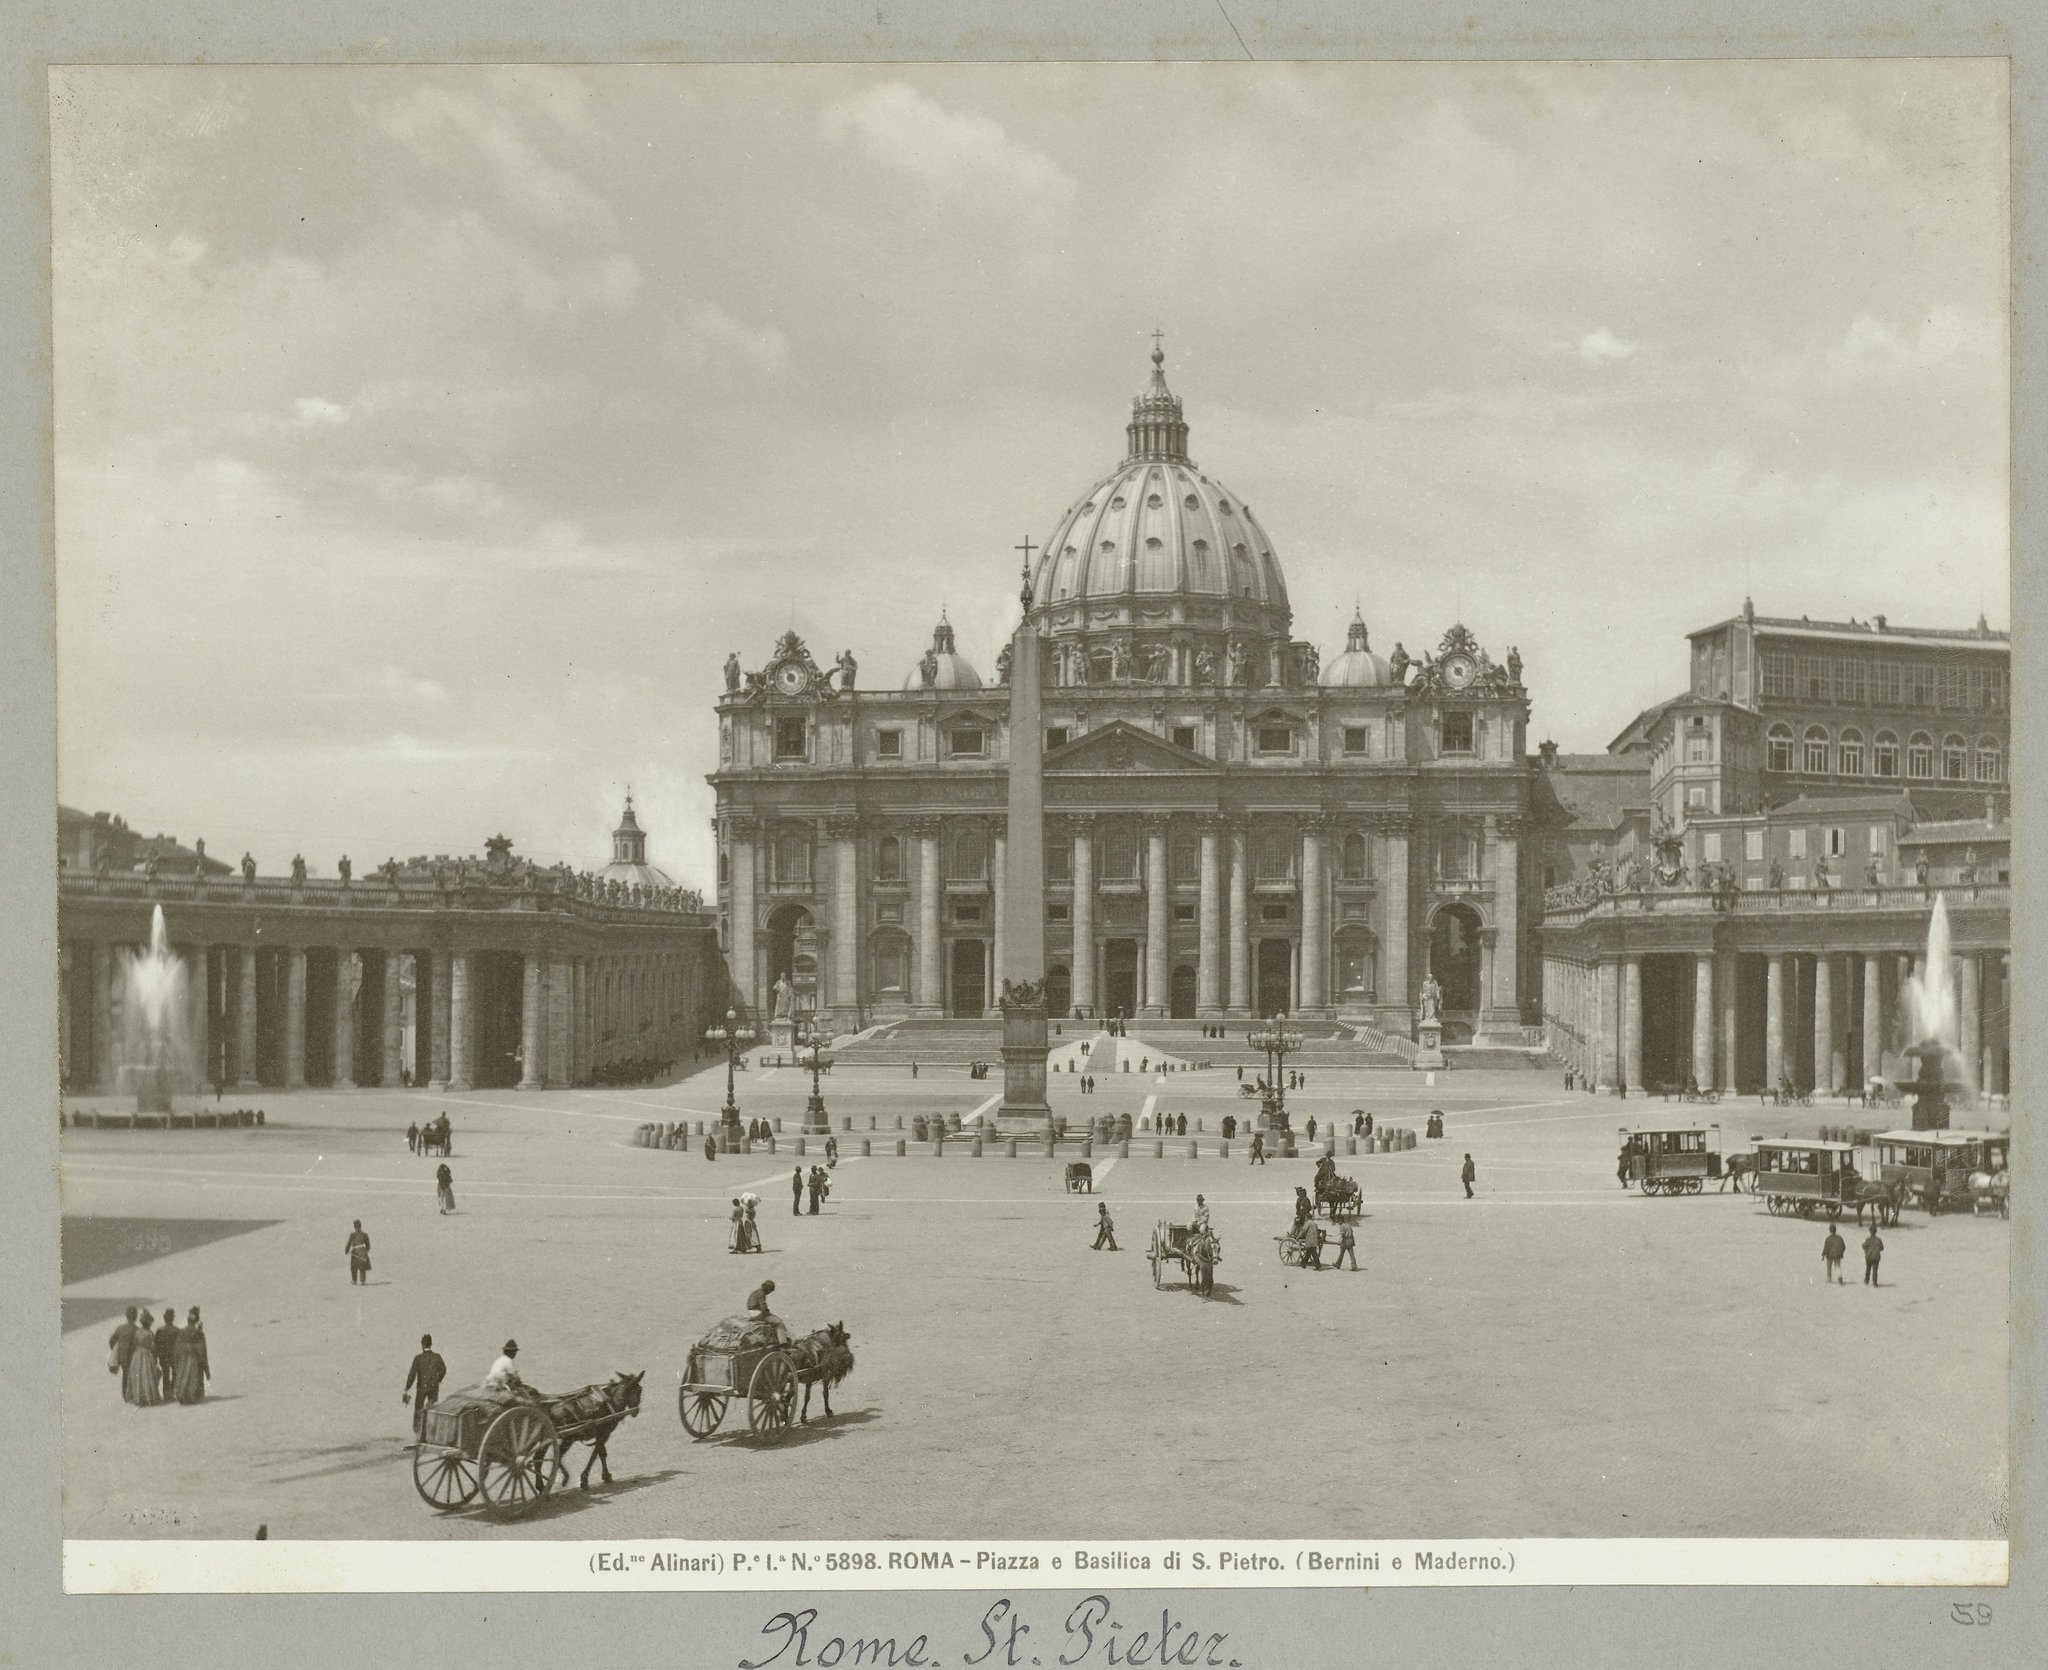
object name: photograph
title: Rome. St. Pieter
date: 1893-1903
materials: cardboard, photographic support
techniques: albumen print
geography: netherlands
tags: sint-pietersbasiliek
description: De Sint Pieter en het Sint Pieterplein in Vaticaanstad. Op het plein rijden paardentrams en rijtuigen.